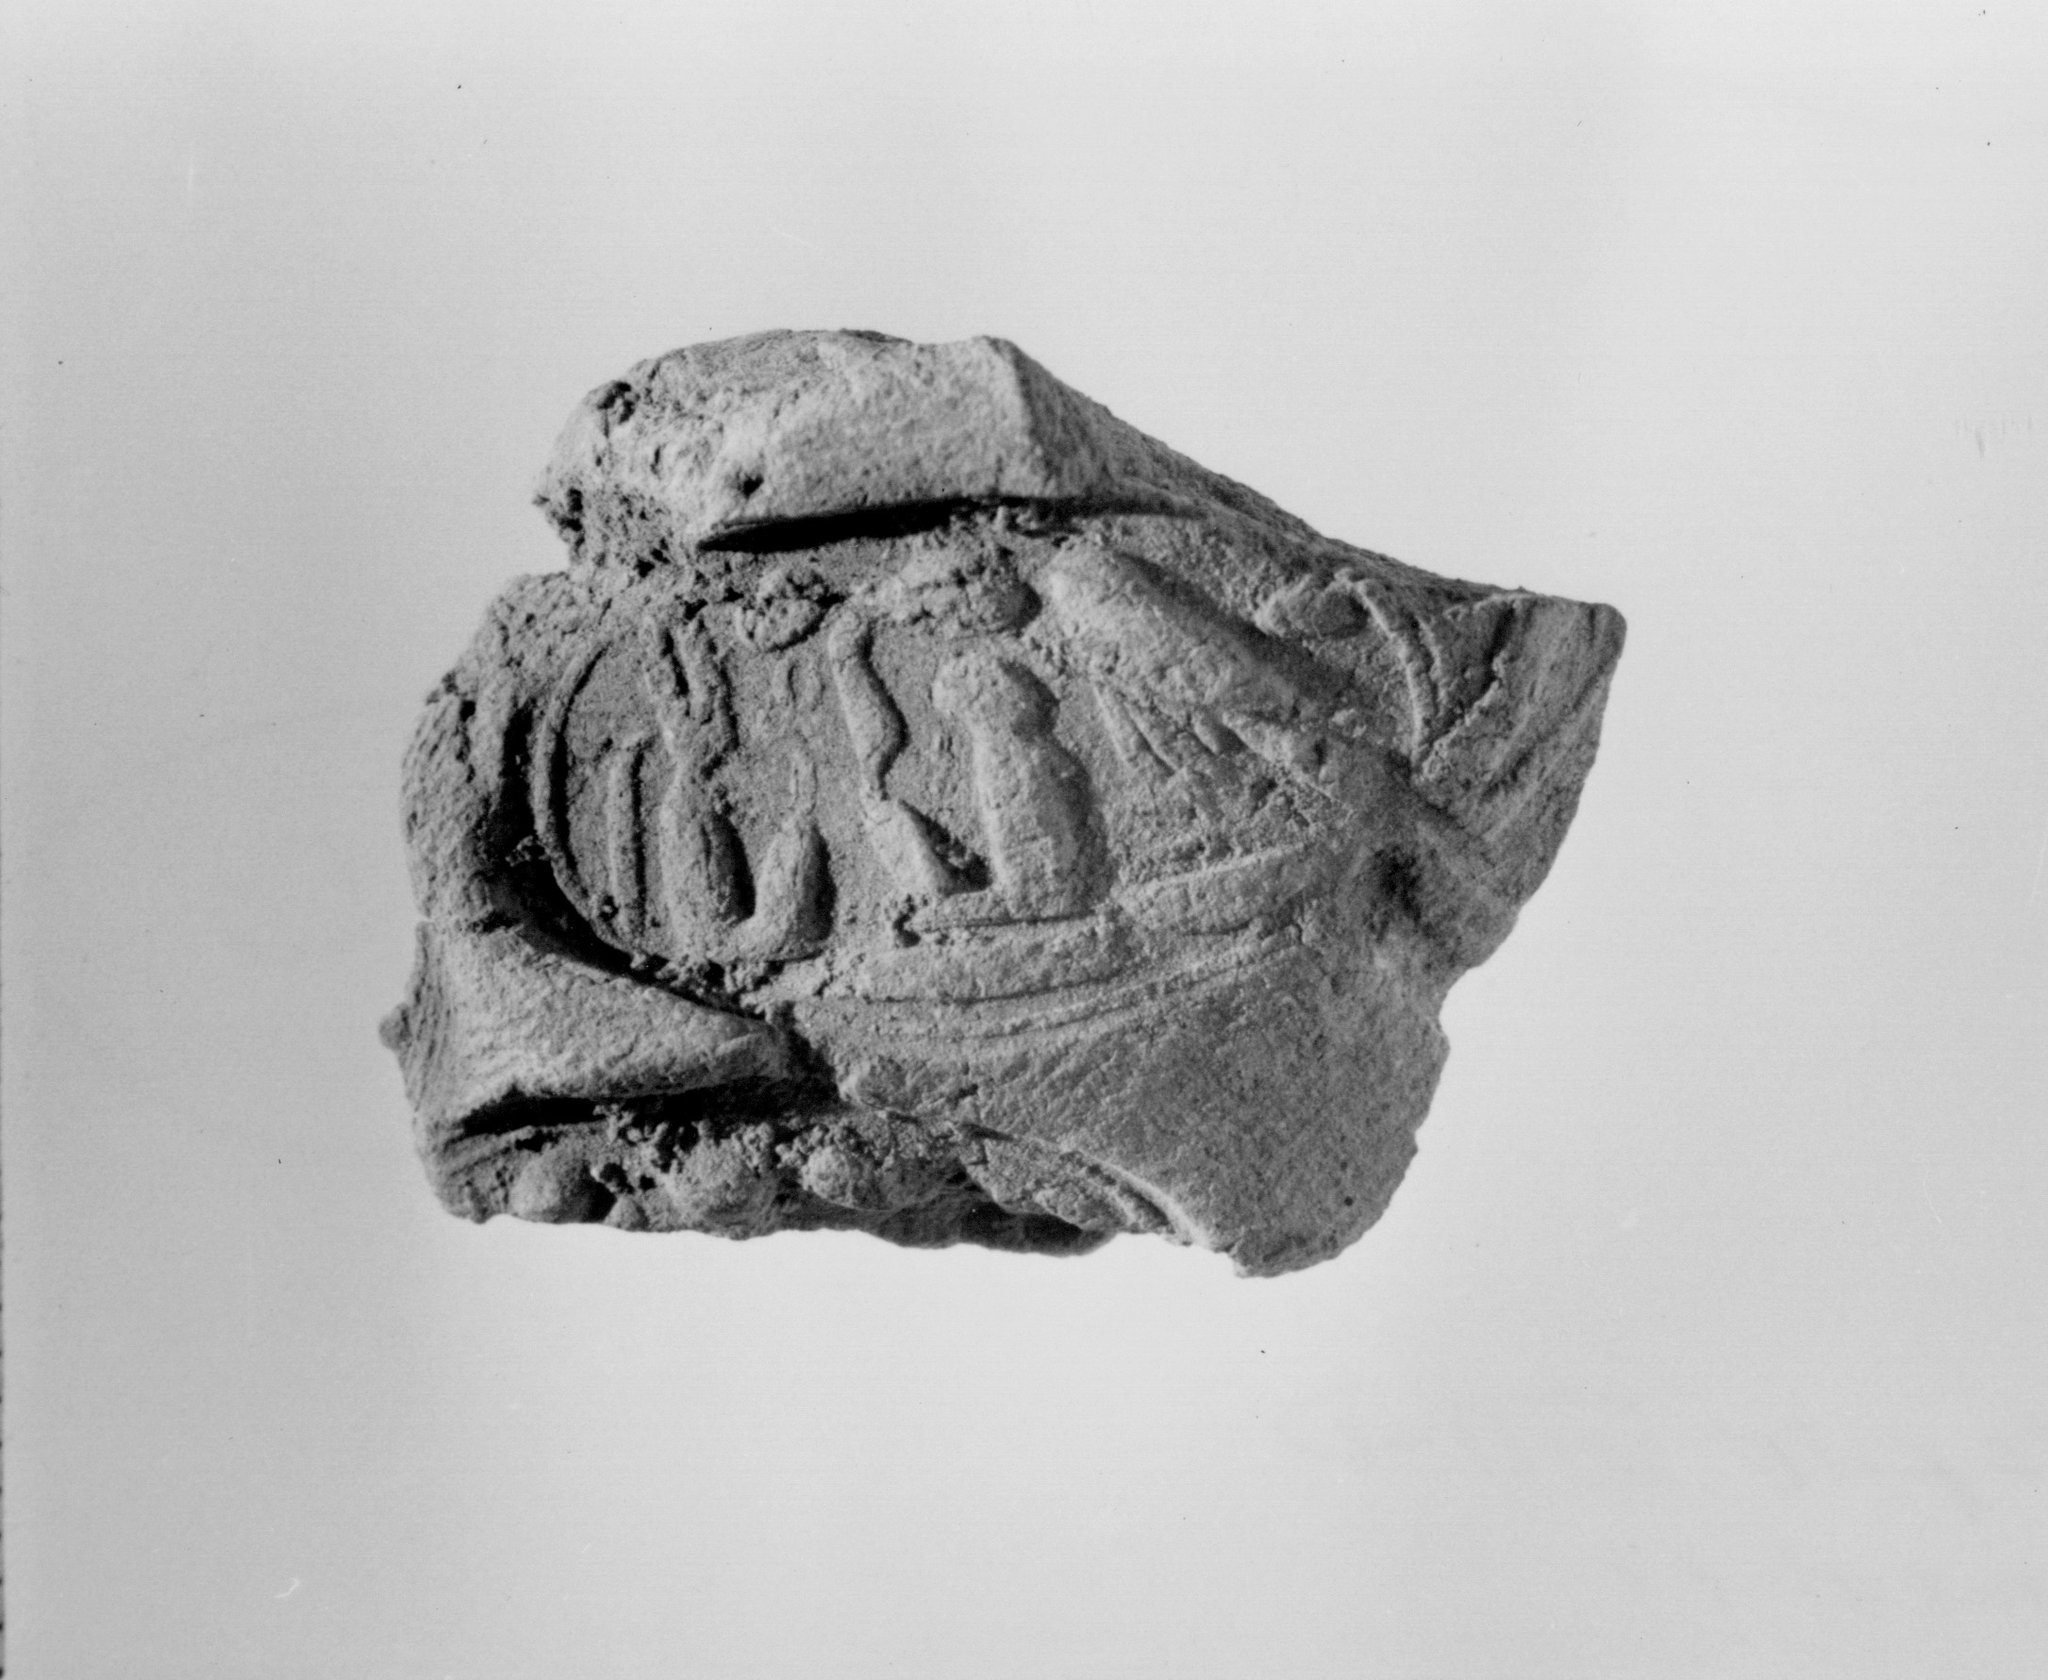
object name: sealing, nebmaatre, amenhotep iii, horus, re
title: Document Sealing With the Throne Name of Amenhotep III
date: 1390-1352 BCE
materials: mud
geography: egypt